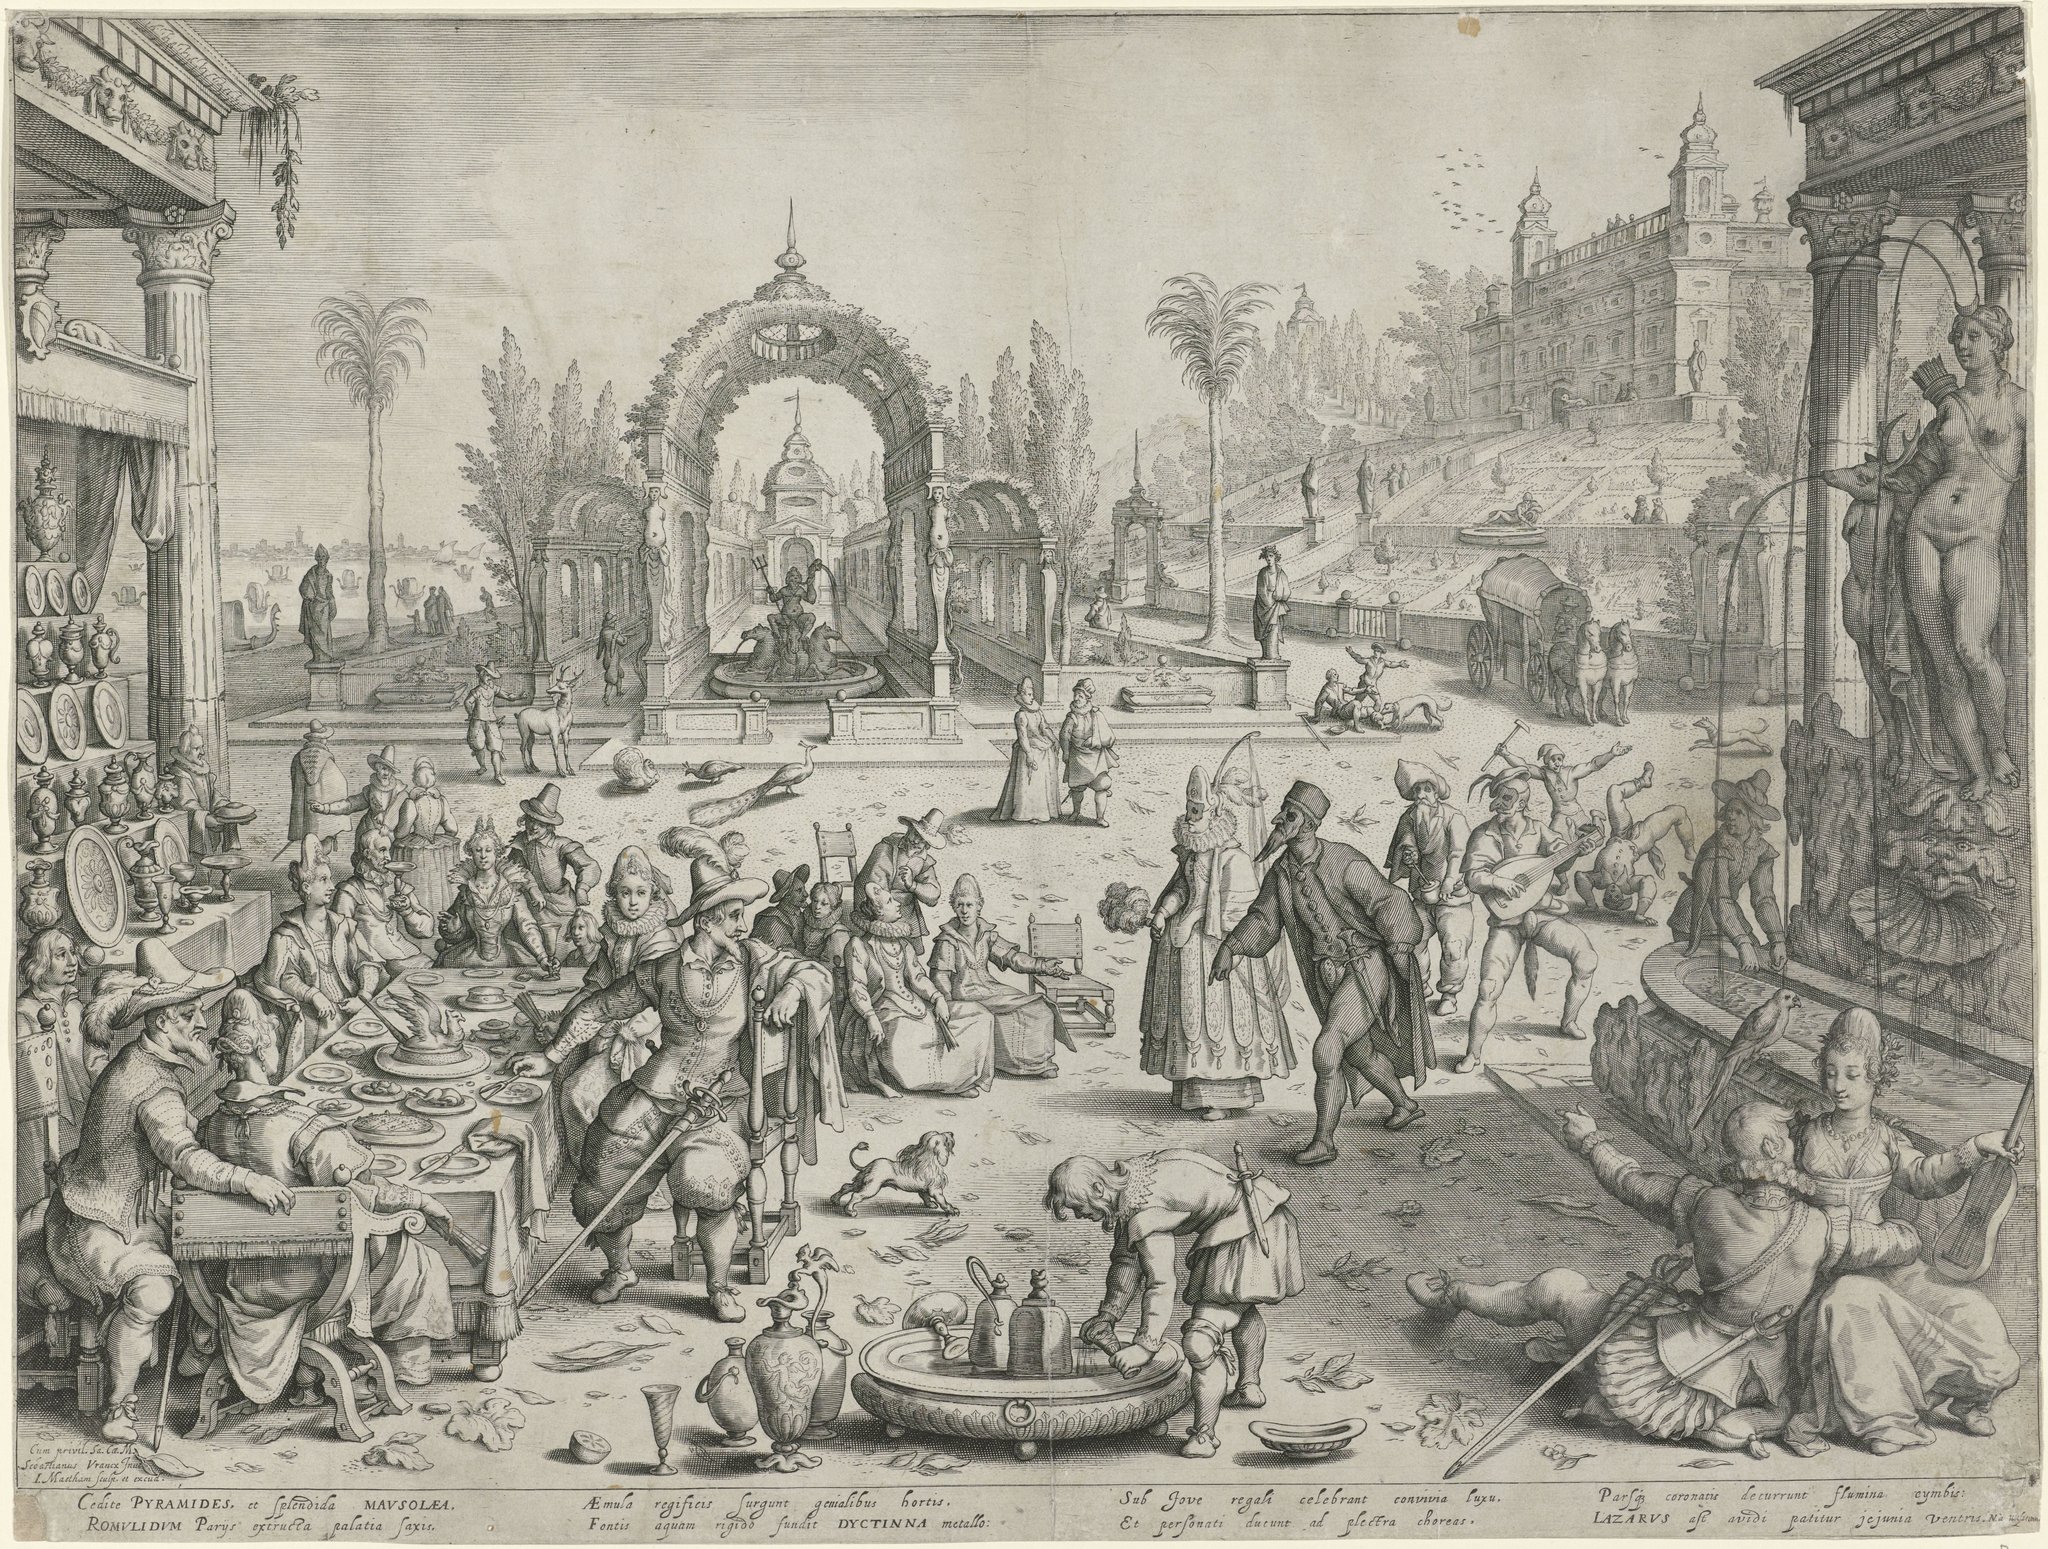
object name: print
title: Parabel van de rijke man en de arme Lazarus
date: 1606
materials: paper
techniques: engraving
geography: haarlem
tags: masquerade, masked ball, the rich man (dives) is feasting, while poor lazarus is starving at the gate (dogs licking lazarus' sores) (luke 16:19-31), ornamental fountain, (dinner-)service displayed on sideboard, laid table: table-ware, table-decoration, etc.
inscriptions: collector's mark: Lugt 240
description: De rijke man uit de parabel uit Luc. 16:19-31, in het midden zittend aan een rijk gedekte tafel, houdt een feestmaal terwijl de arme Lazarus honger lijdt en zijn wonden gelikt worden door de honden rechts in de achtergrond. Vele elegant geklede figuren feesten mee met de rijke man, waaronder gemaskerde figuren en minnekozende paren. Een dienaar vult glazen en kruiken. Rechts op de achtergrond een paleis